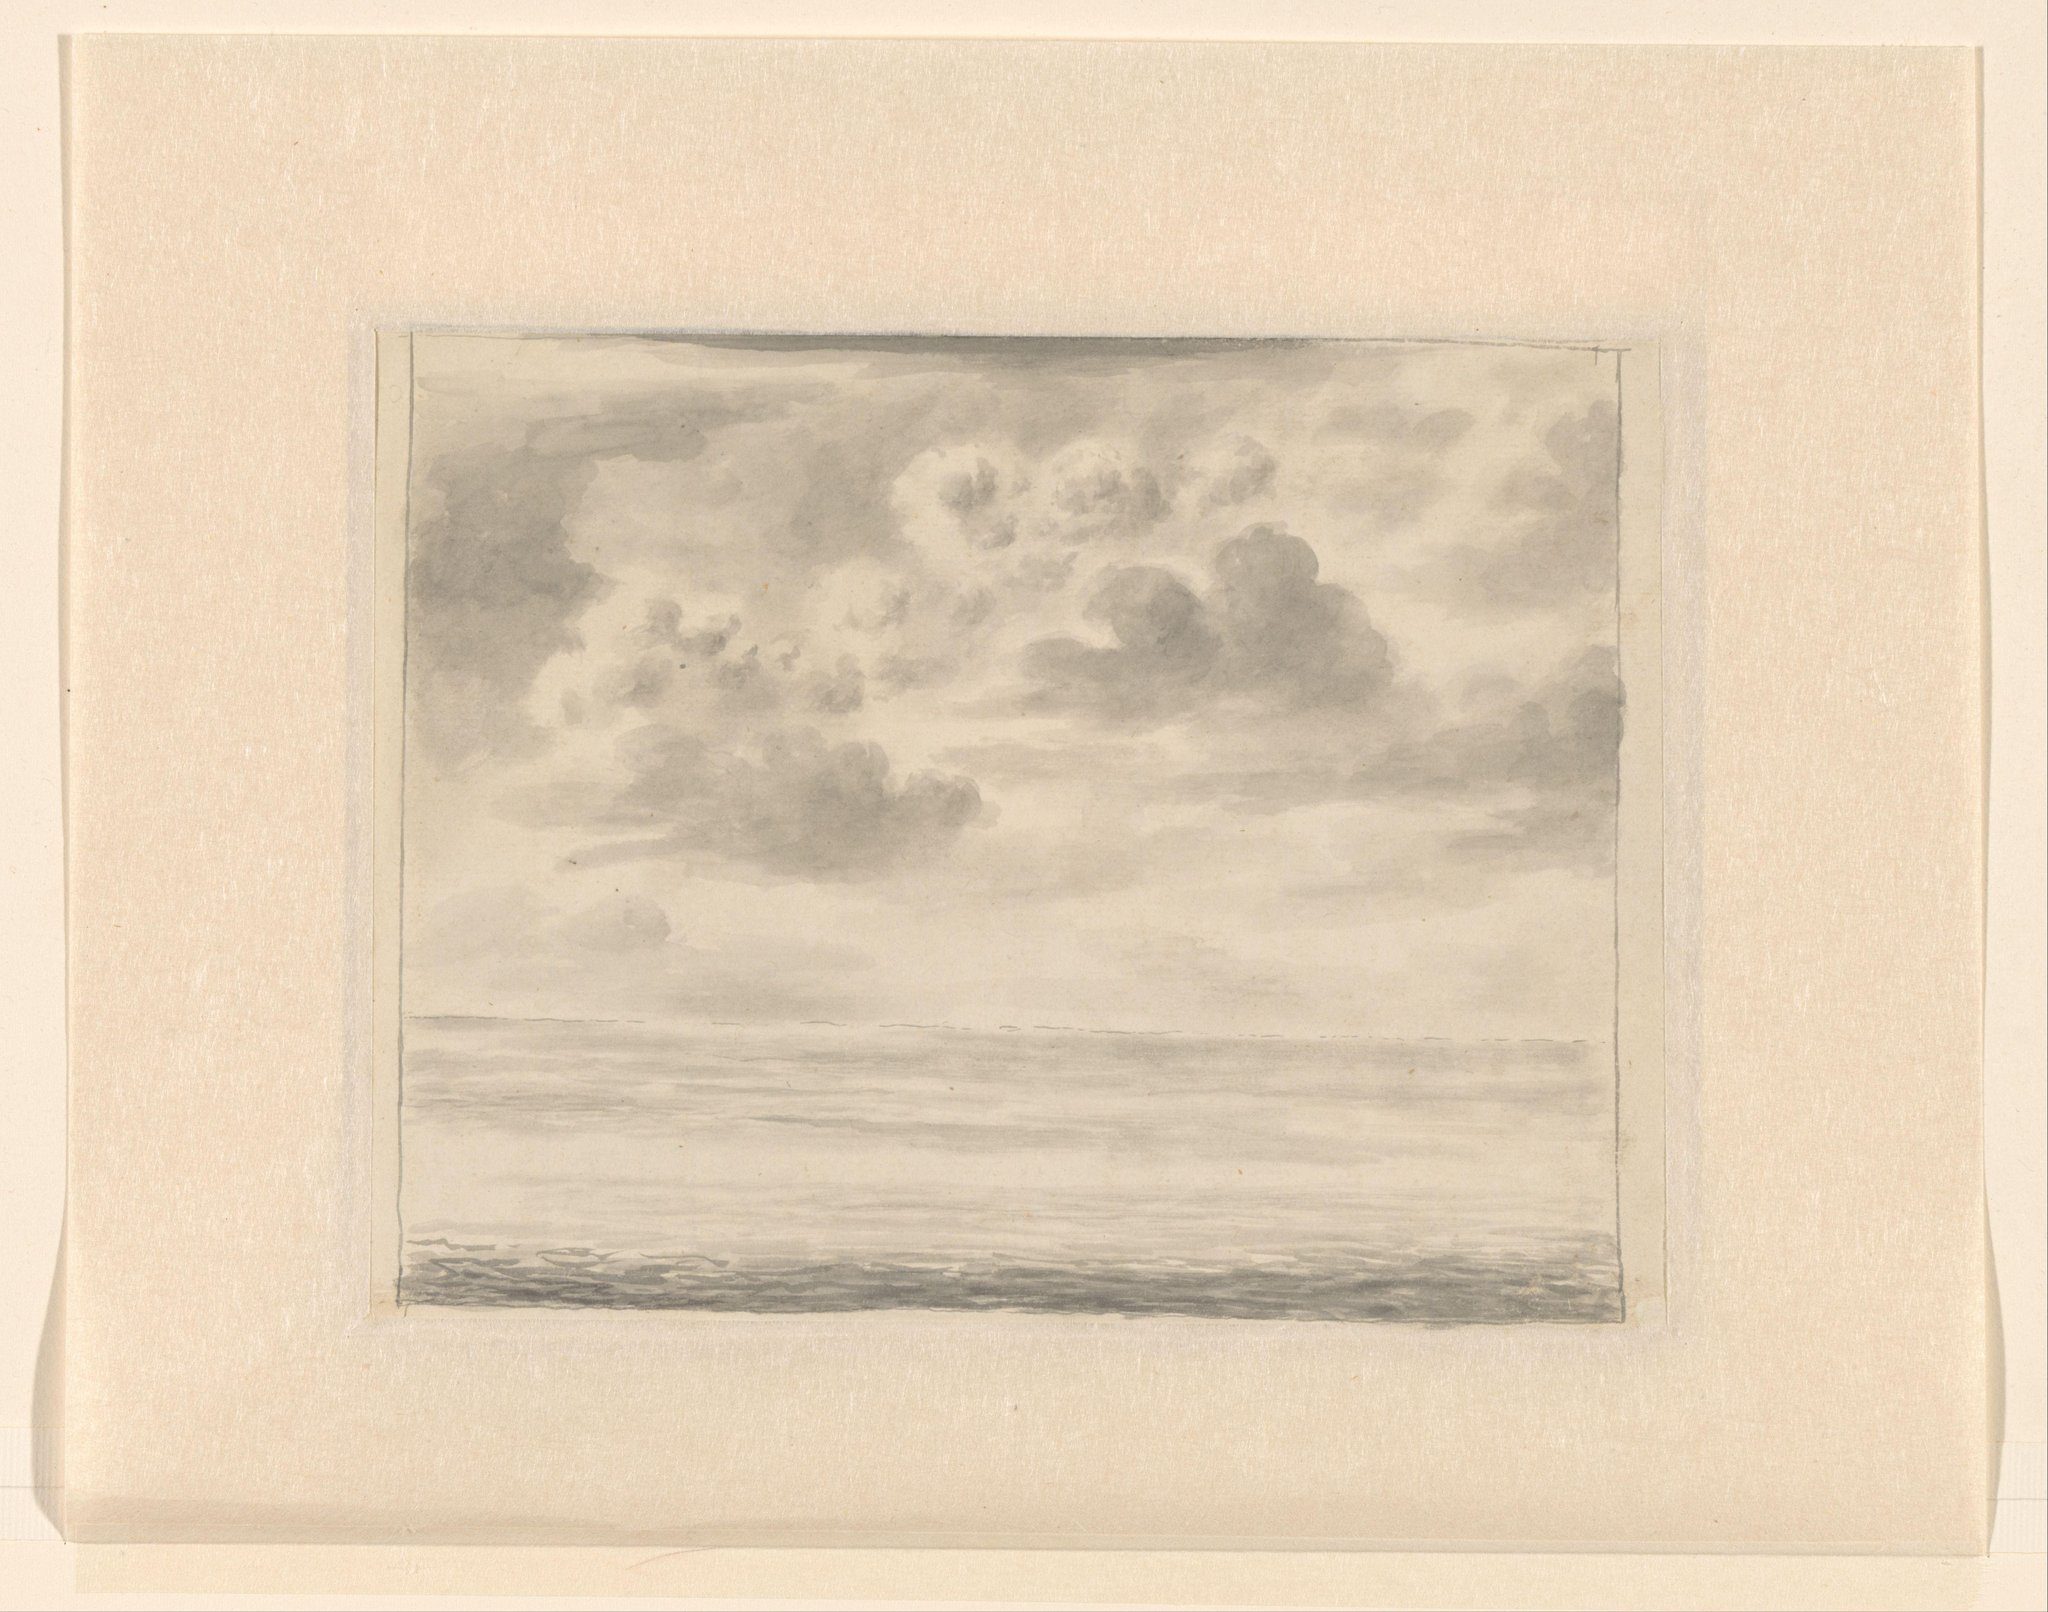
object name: drawing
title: Zeegezicht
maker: pieter idserts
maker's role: draughtsman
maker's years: 1698-1781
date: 1708-1781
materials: paper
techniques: brush